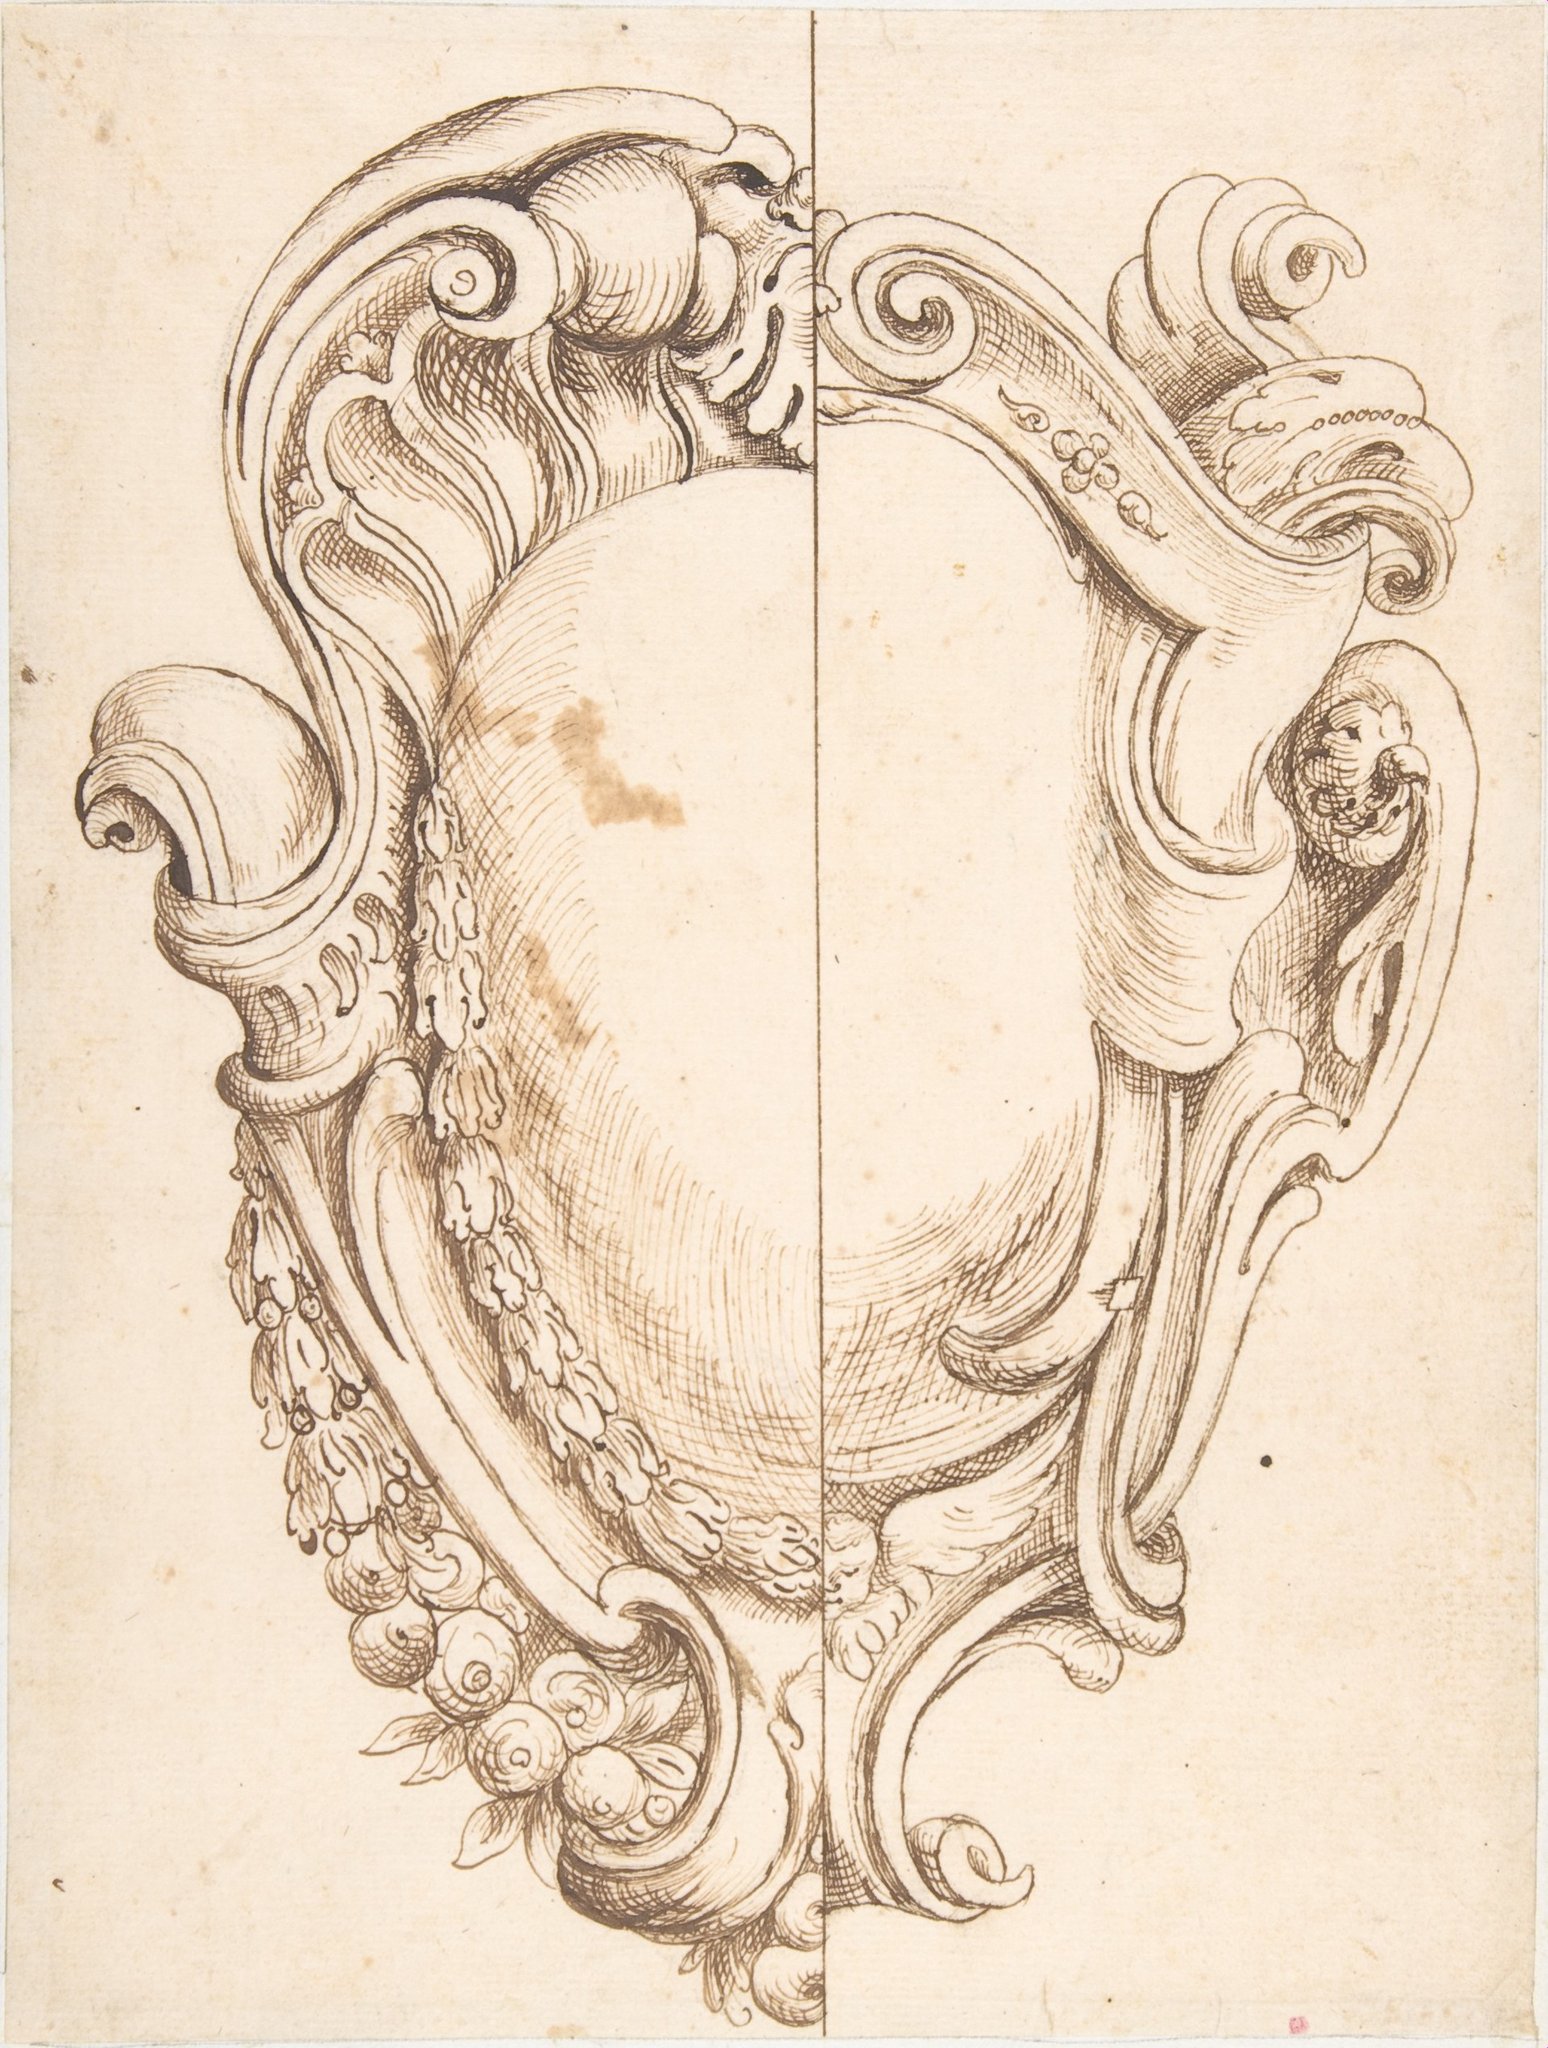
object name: drawing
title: Study with Two Alternate Designs for a Cartouche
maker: anonymous, italian, 19th century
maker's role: artist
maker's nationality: italian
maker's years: 1800-1900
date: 1801-1900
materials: chalk, graphite, ink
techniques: pen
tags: cartouches